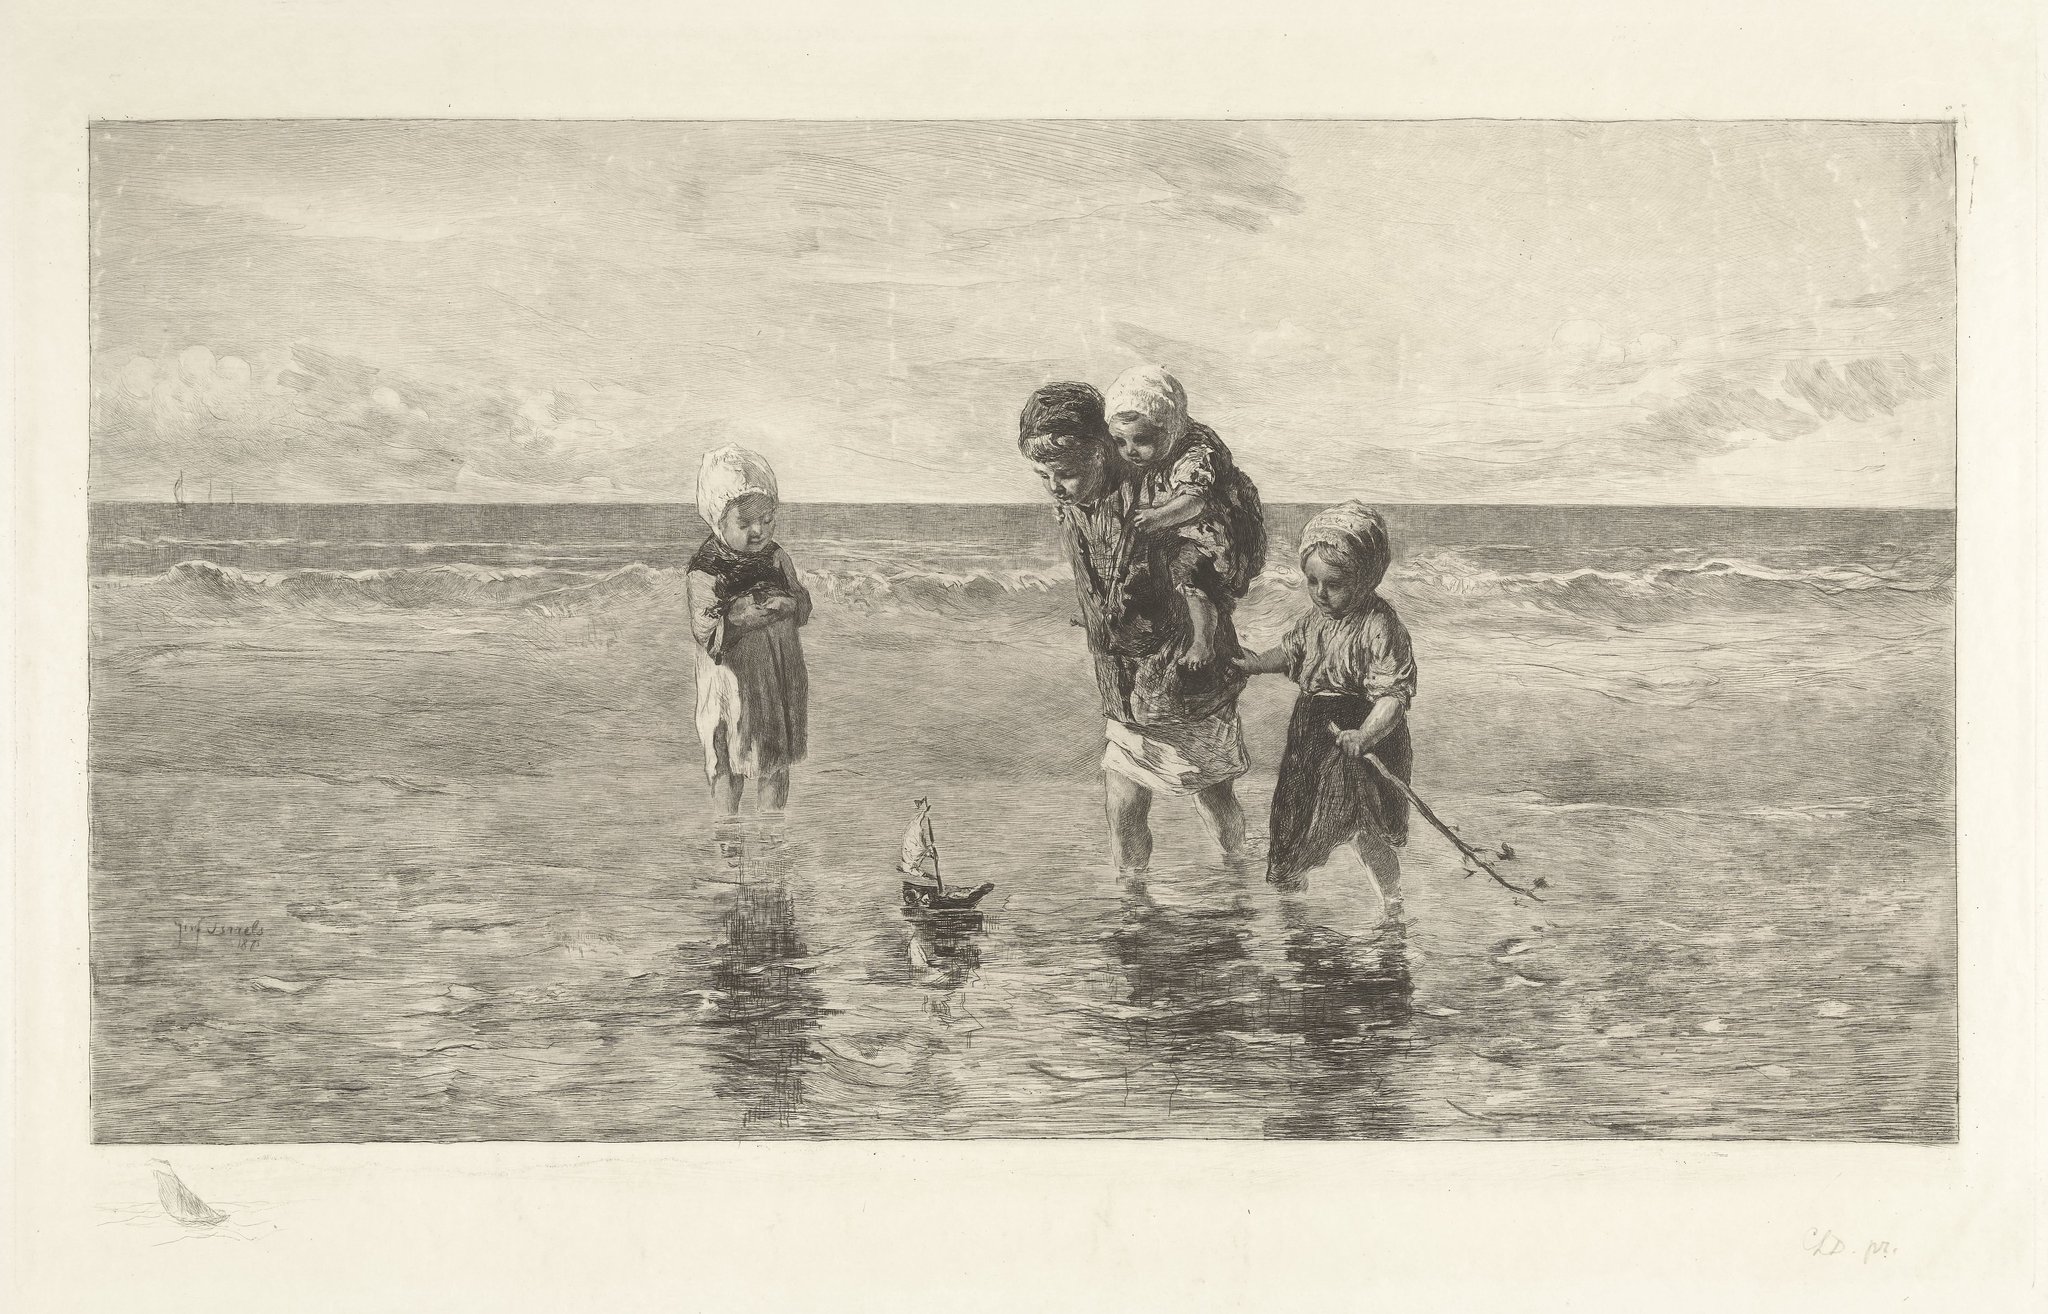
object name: print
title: Kinderen der zee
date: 1888-1892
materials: paper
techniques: drypoint, etching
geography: netherlands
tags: child, (playing with) toys, in or beside the water (on the beach)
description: Vier kinderen spelen met een zelfgemaakt zeilbootje op het strand in een geul gevuld met zeewater. Een jongen met een kind op de rug en twee meisjes staan in het ondiepe water en zij kijken aandachtig naar de verrichtingen van het speelgoedbootje. Achter hen ligt de branding. In ondermarge remarque met zeilboot.